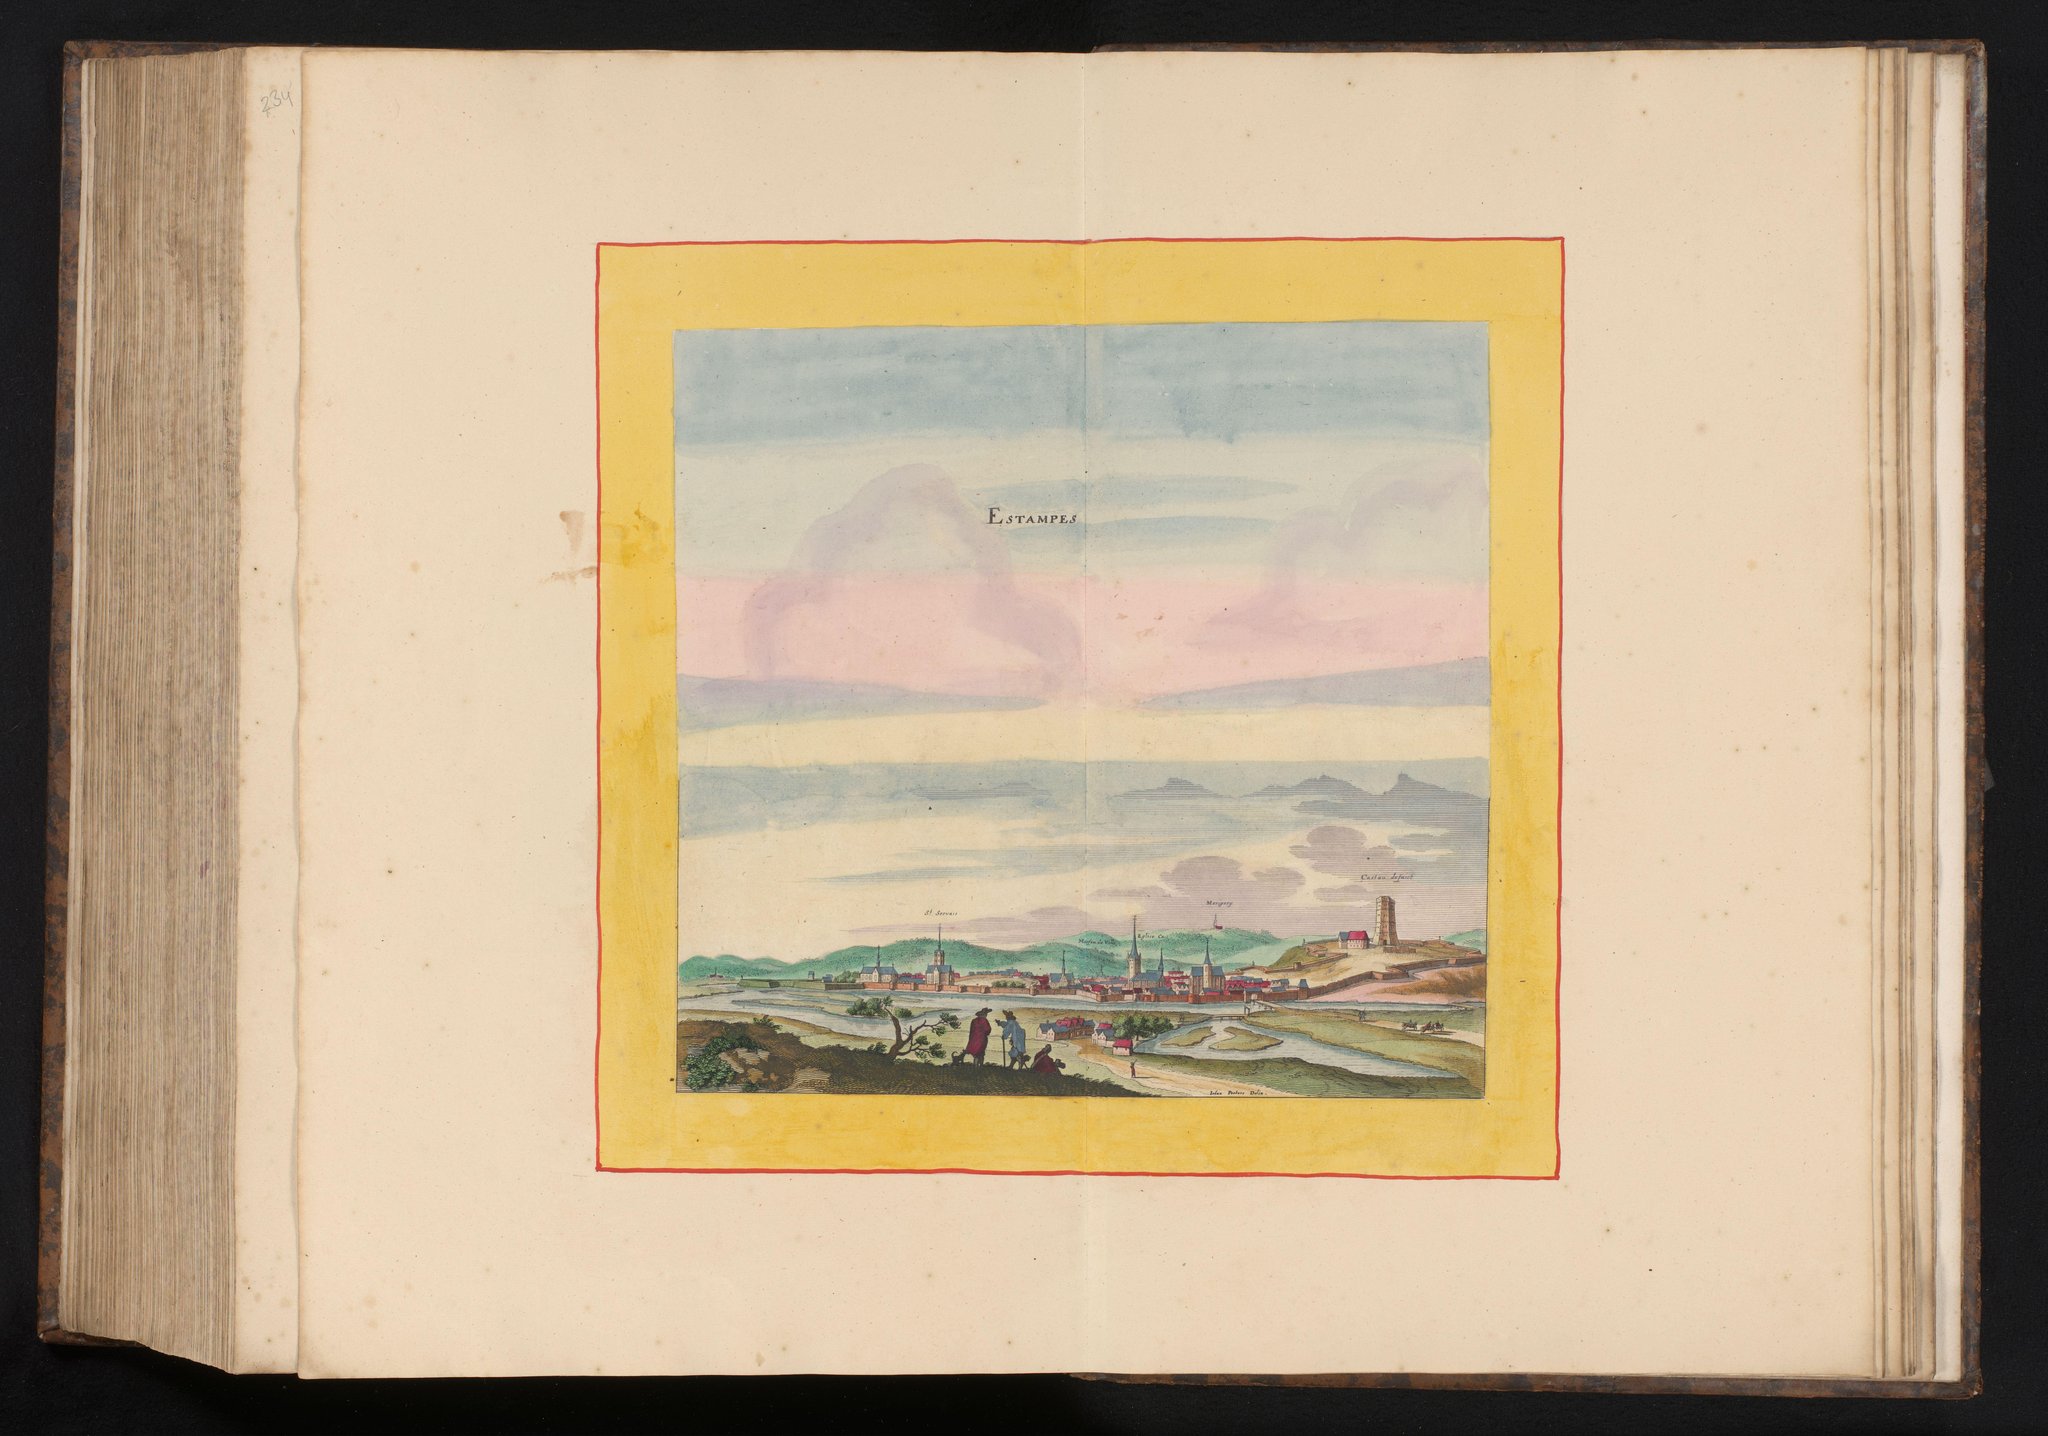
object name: print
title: Estampes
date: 1655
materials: paper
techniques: engraving, etching, hand coloring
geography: frankfurt am main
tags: city-view in general; 'veduta', river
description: Prent origineel vervaardigd als boekillustratie voor: Zeiller, Martin. Topographia Galliae, oder Beschreibung und Contrafaitung der vornehmbsten und bekantisten Oerter in dem mächtigen und grossen Königreich Frankreich, 13 delen. Frankfurt am Main: Caspar Merian, 1655-1661. De prent werd voor het eerst gepubliceerd in deel 1: Topographia Galliae, 1655. De prent is langs de bovenrand van de voorstelling afgescheurd. De titel is hoger opgeplakt. De voorstelling is aan de bovenzijde aangevuld met een geschilderde lucht.